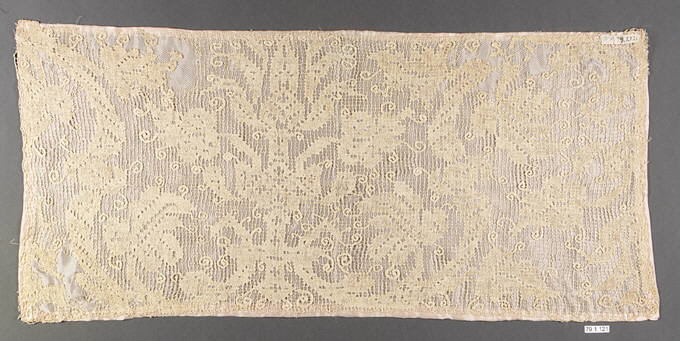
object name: fragment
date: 1501-1600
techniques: embroidery